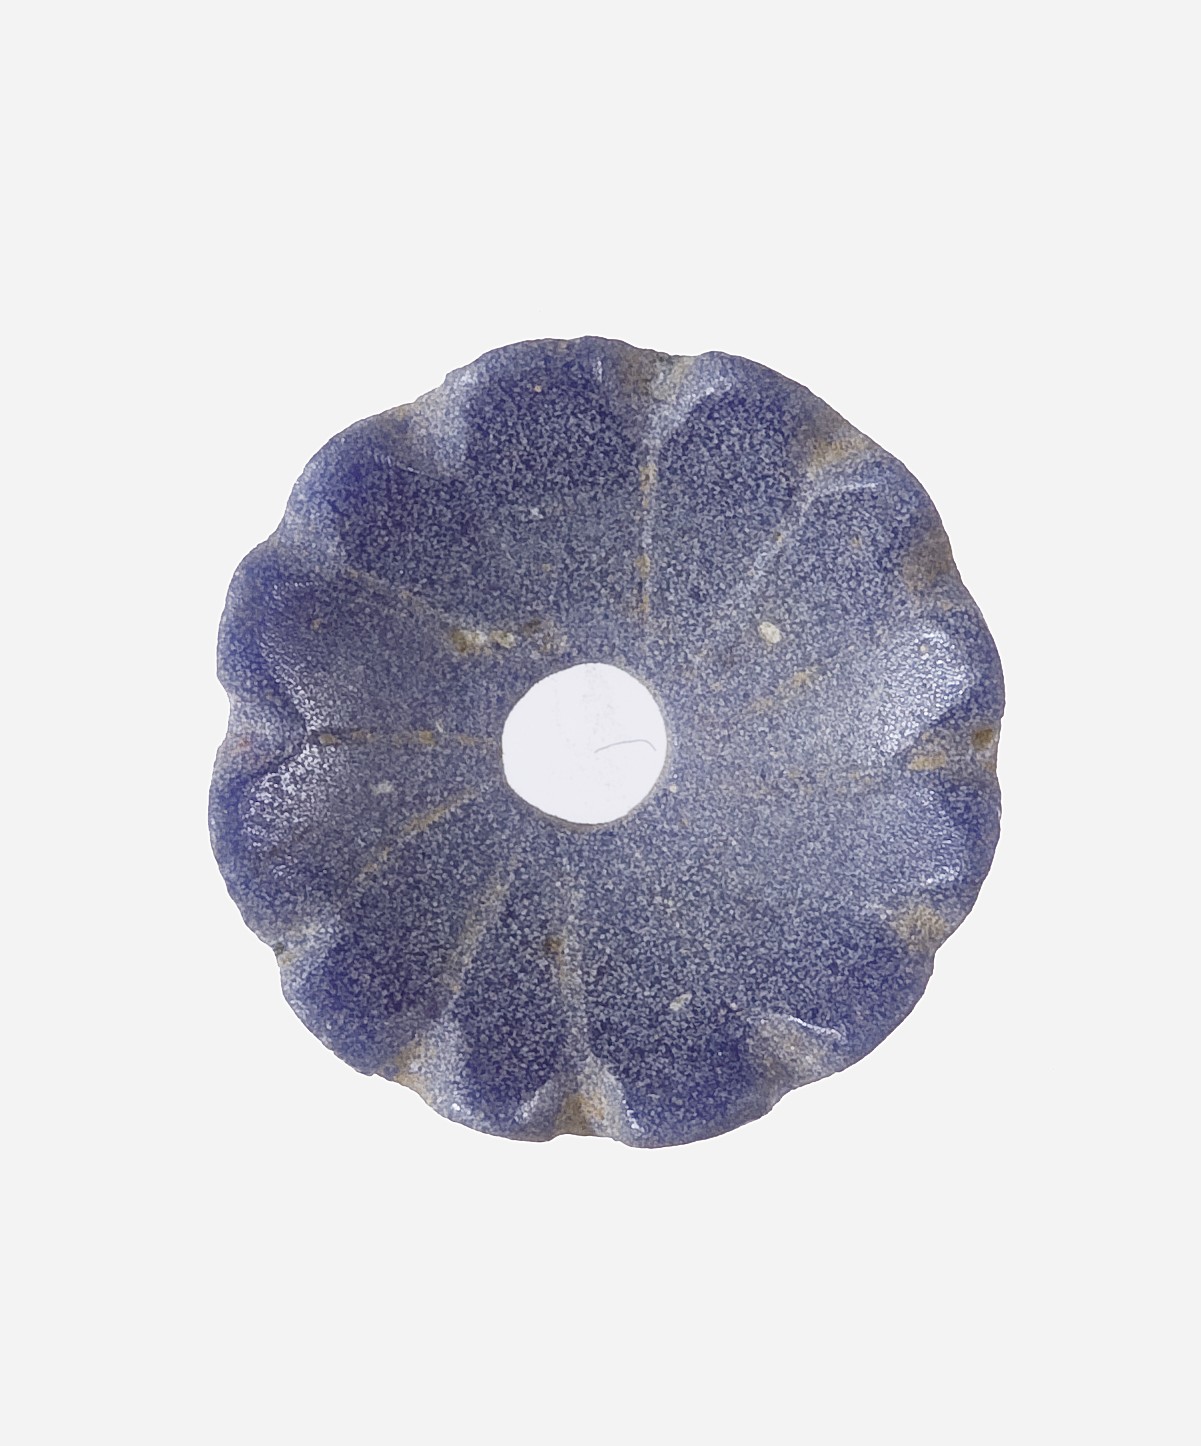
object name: pendant, rosette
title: Rosette Pendant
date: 1390-1352 BCE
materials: faience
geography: egypt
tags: flowers